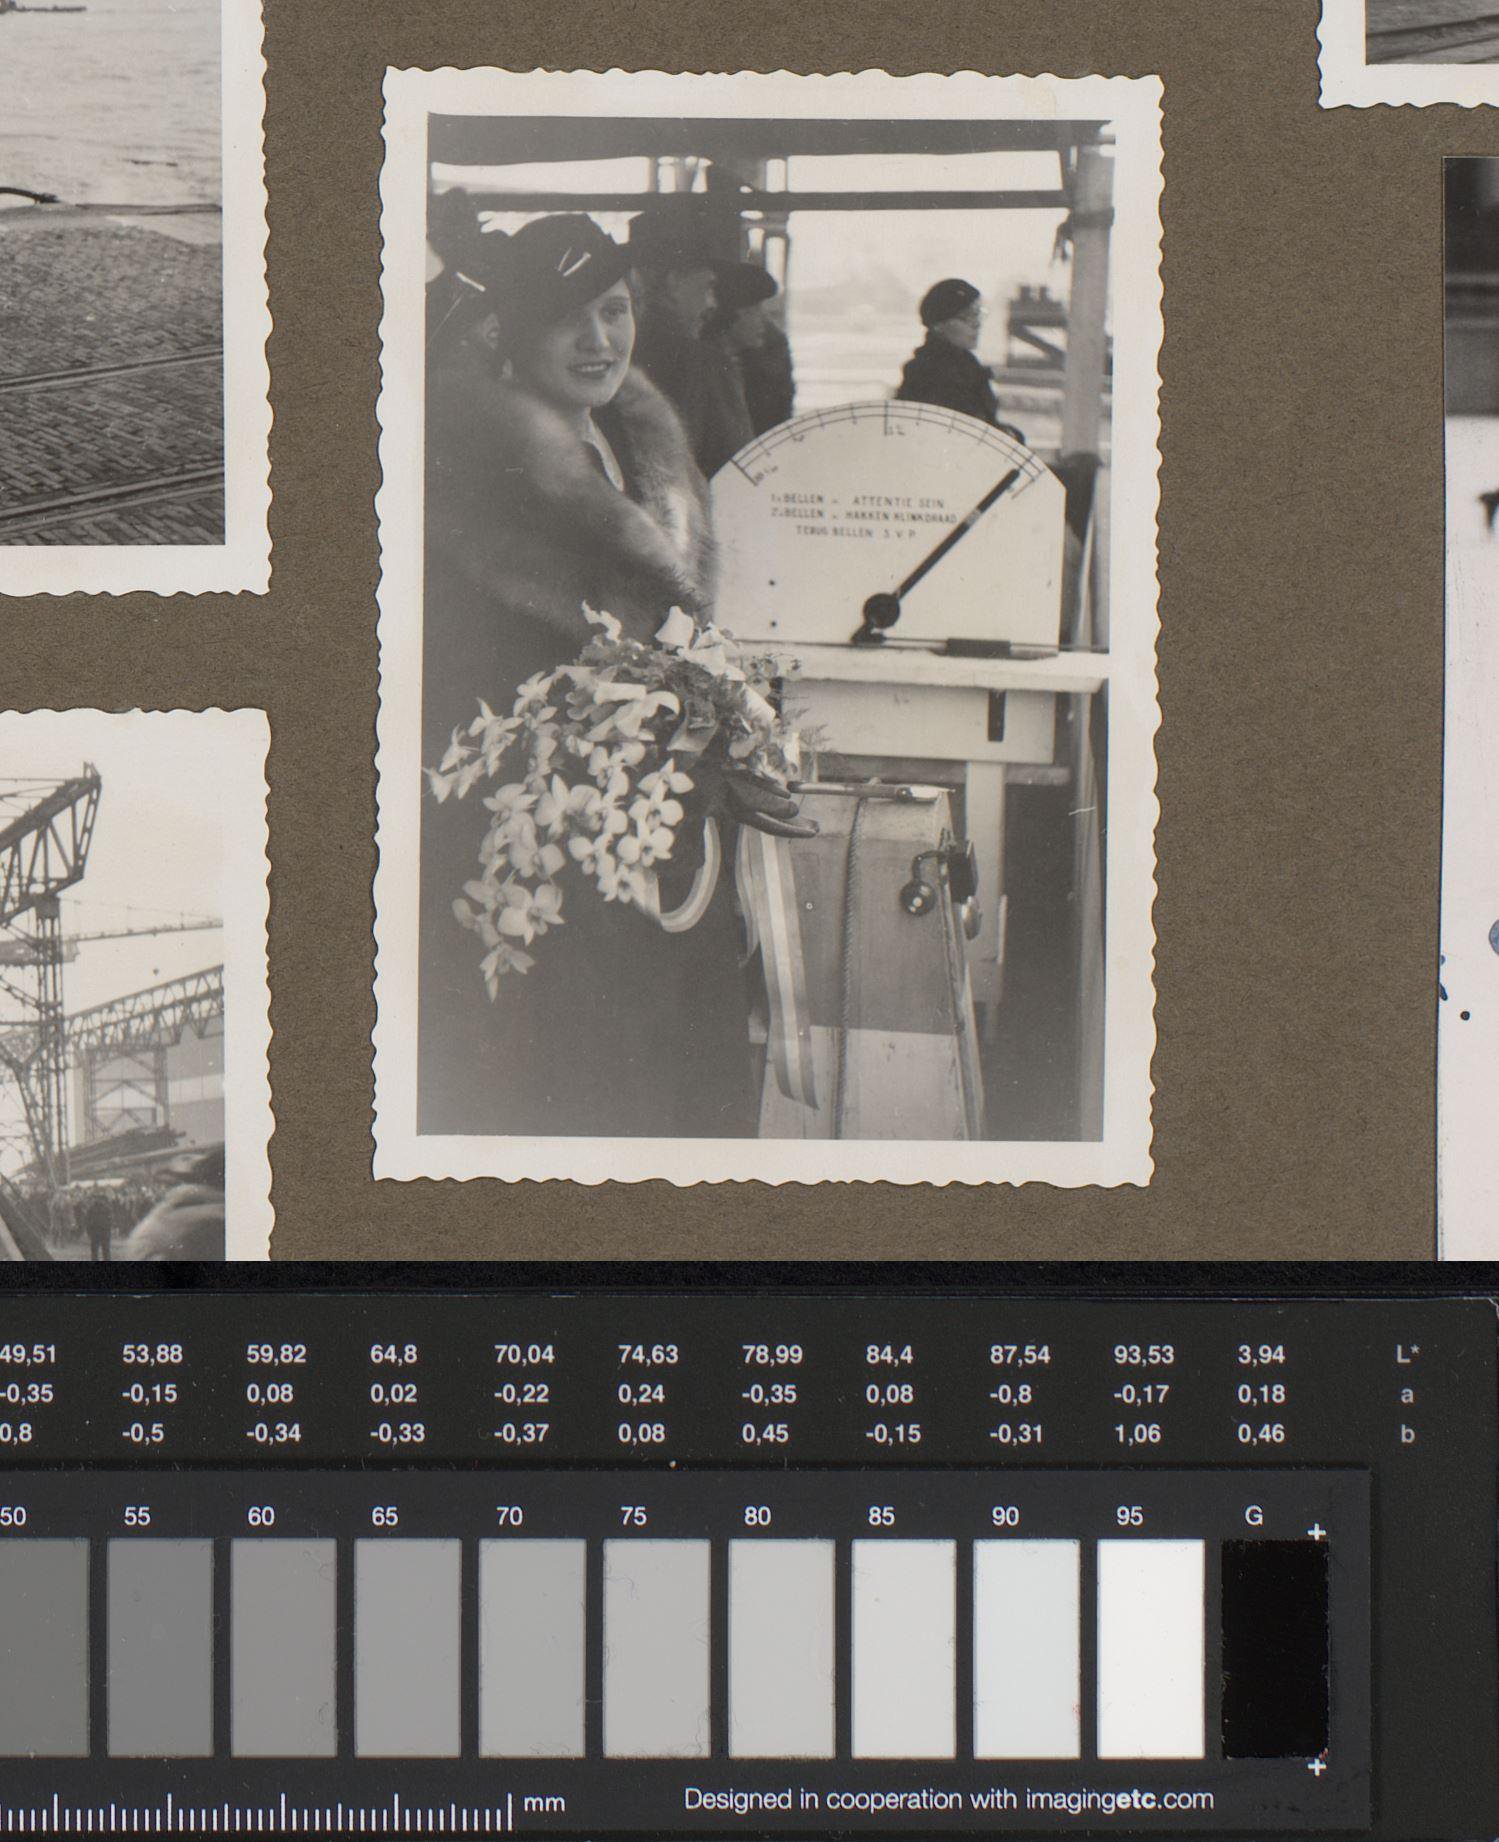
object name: photograph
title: Portret van Corry Mak van Waay-Zulver bij de doop van het schip Sunetta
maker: Anonymous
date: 1934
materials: paper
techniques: gelatin silver print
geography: rotterdam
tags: historical persons - bb - woman, christening a ship, rotterdam